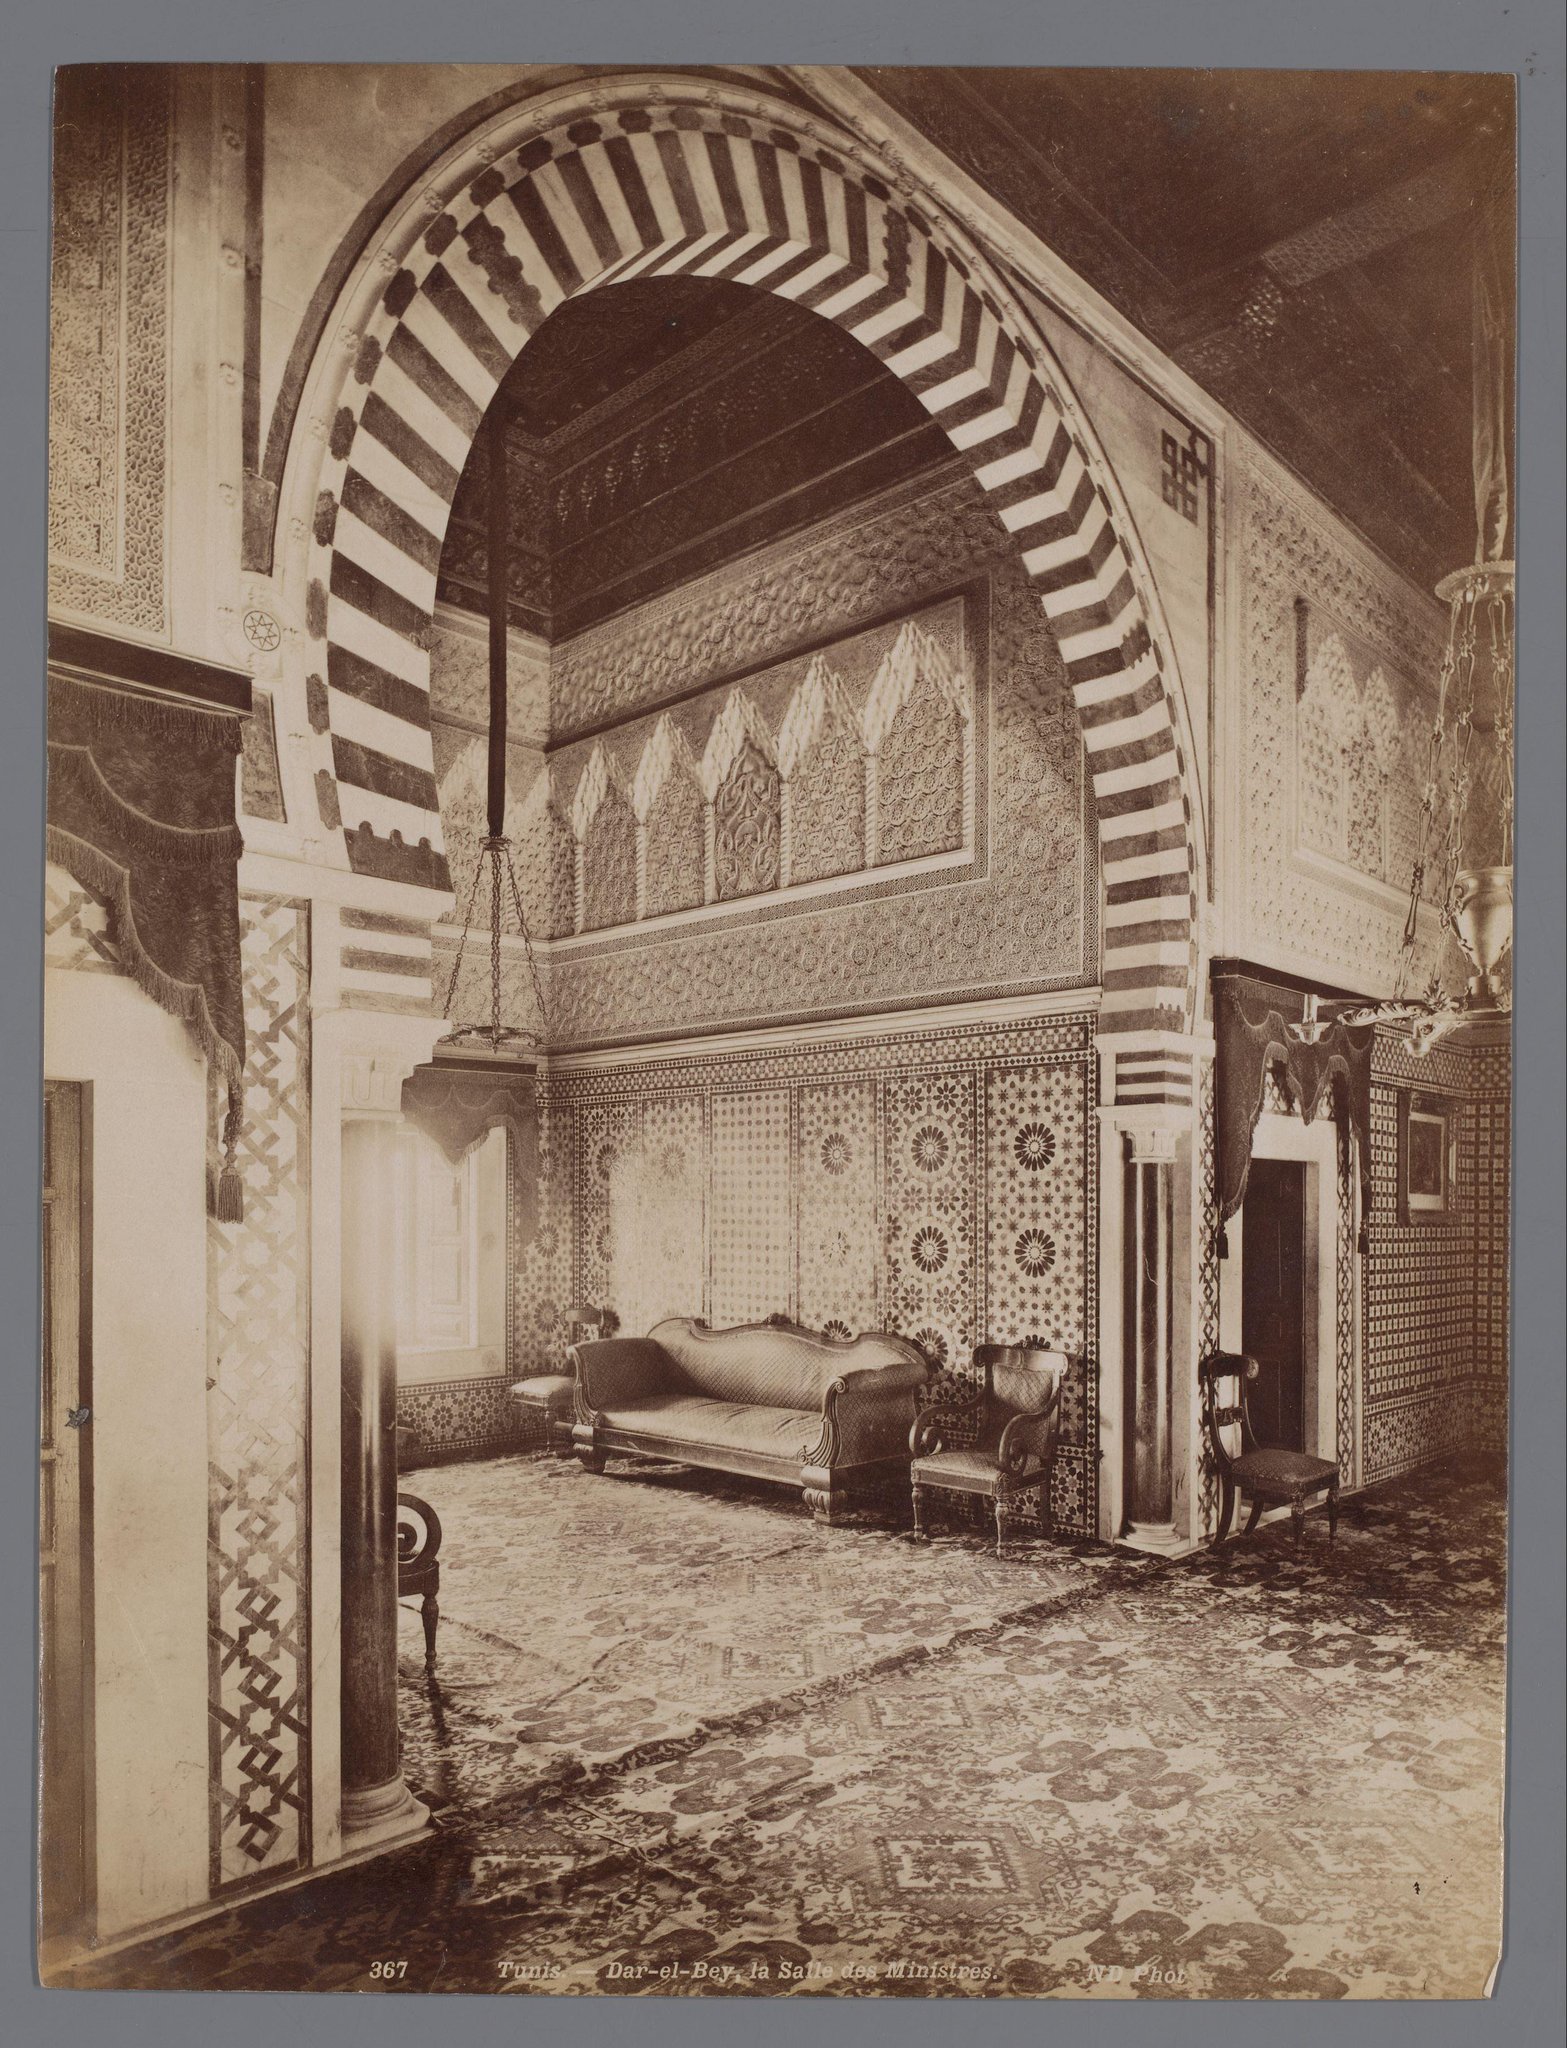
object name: photograph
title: Tunis, Dar-el-Bey, la Salle des Ministres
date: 1863-1900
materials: paper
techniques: albumen print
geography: medina of tunis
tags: palace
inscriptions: number: ‘367’